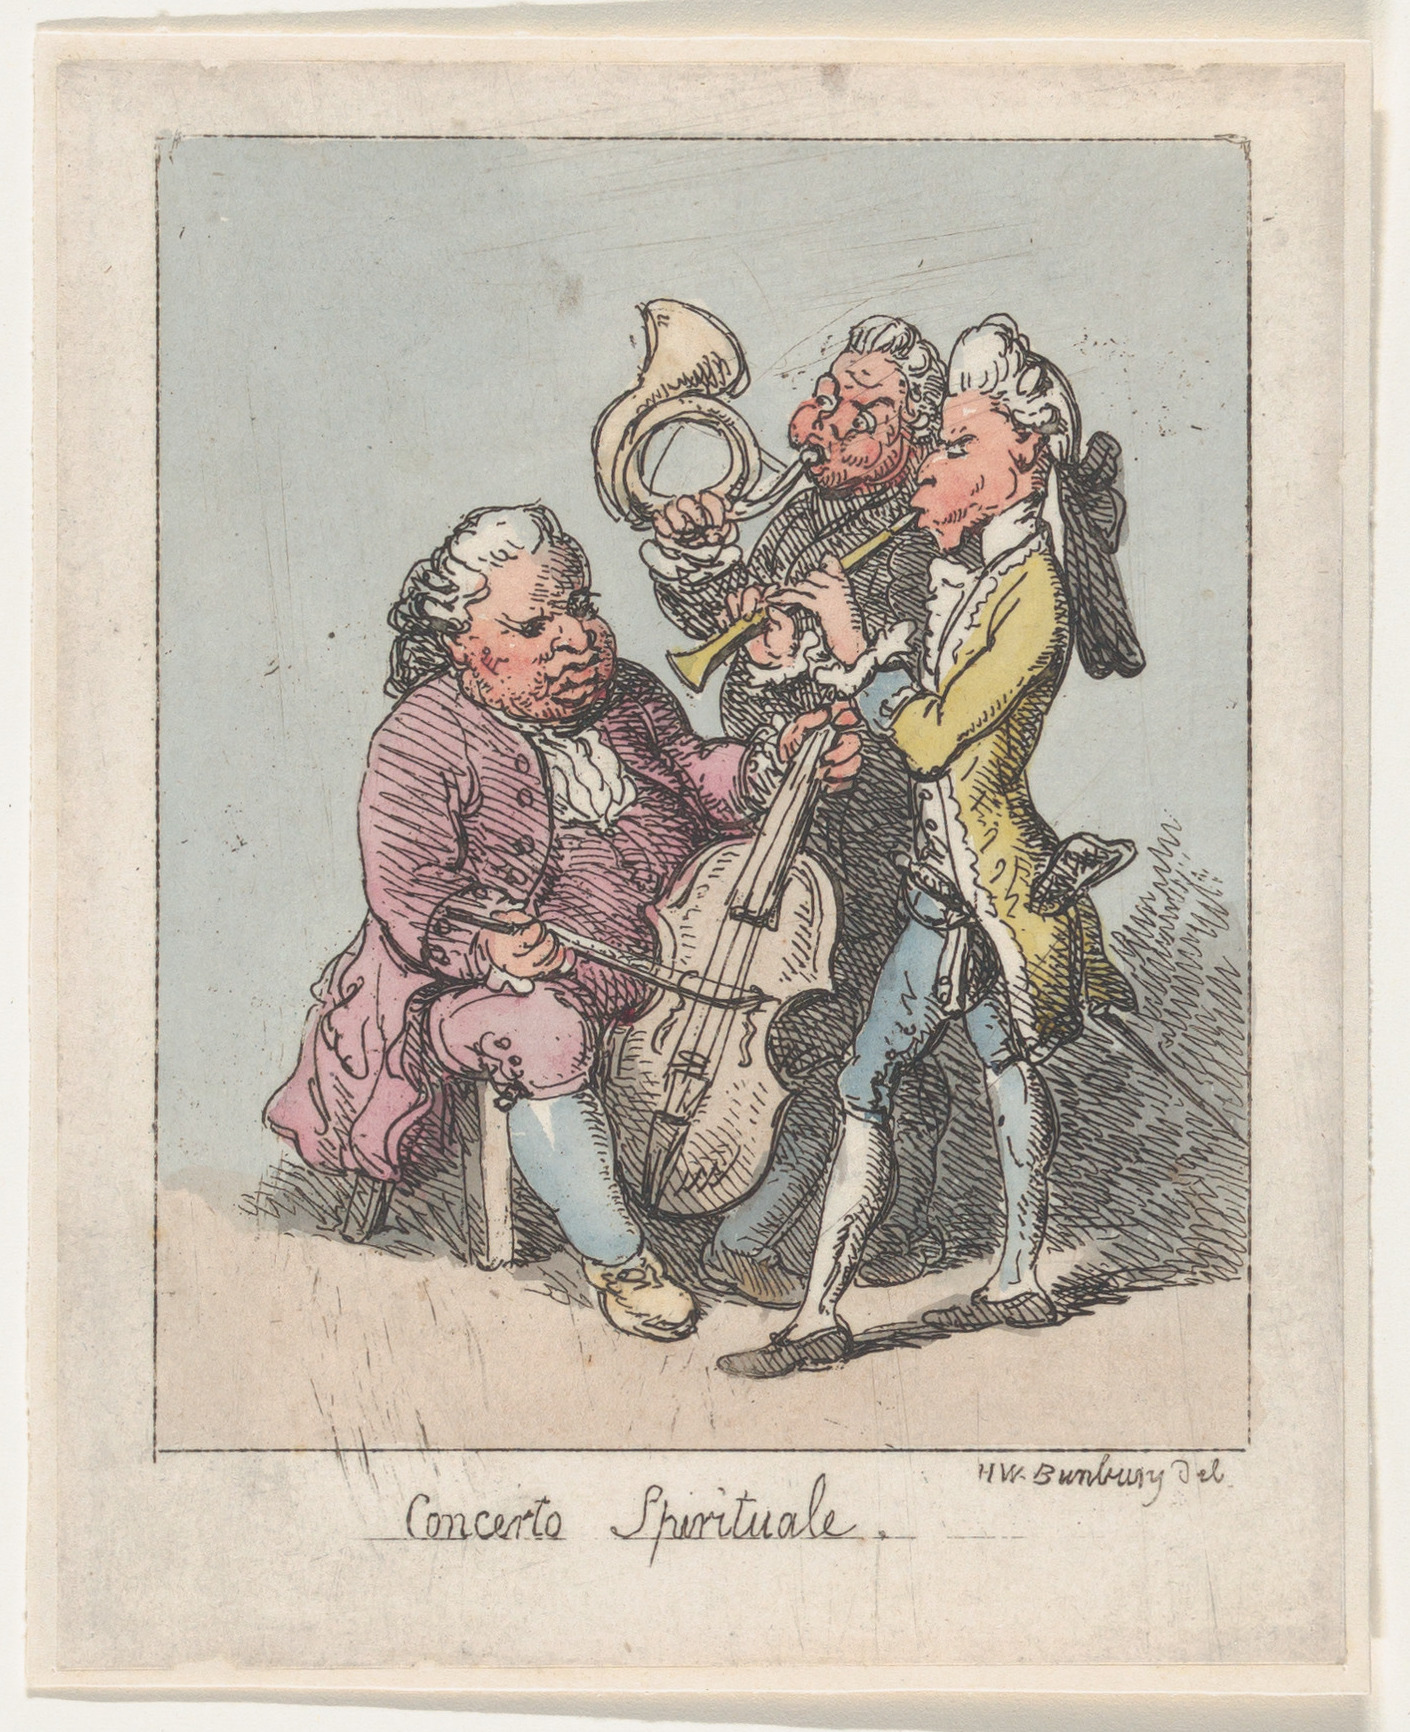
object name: print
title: Concerto Spirituale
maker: henry william bunbury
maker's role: artist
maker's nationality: british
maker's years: 1750-1811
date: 1803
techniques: etching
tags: musical instruments,satire,men,musicians